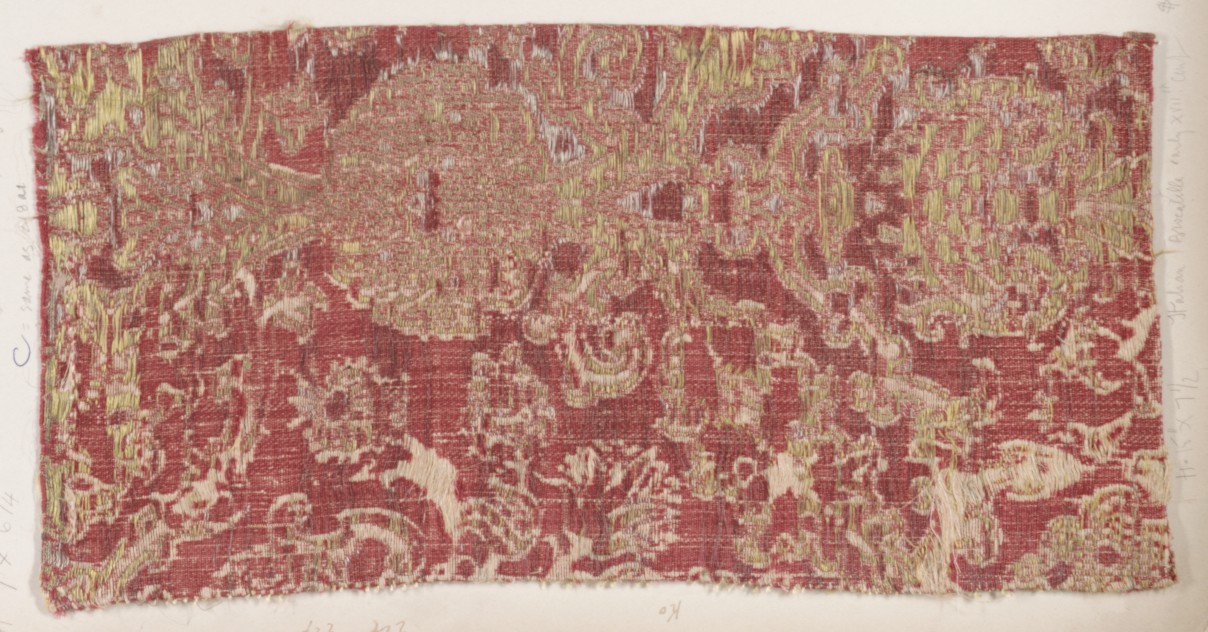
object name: fragment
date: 1501-1700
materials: metal thread, silk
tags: flowers